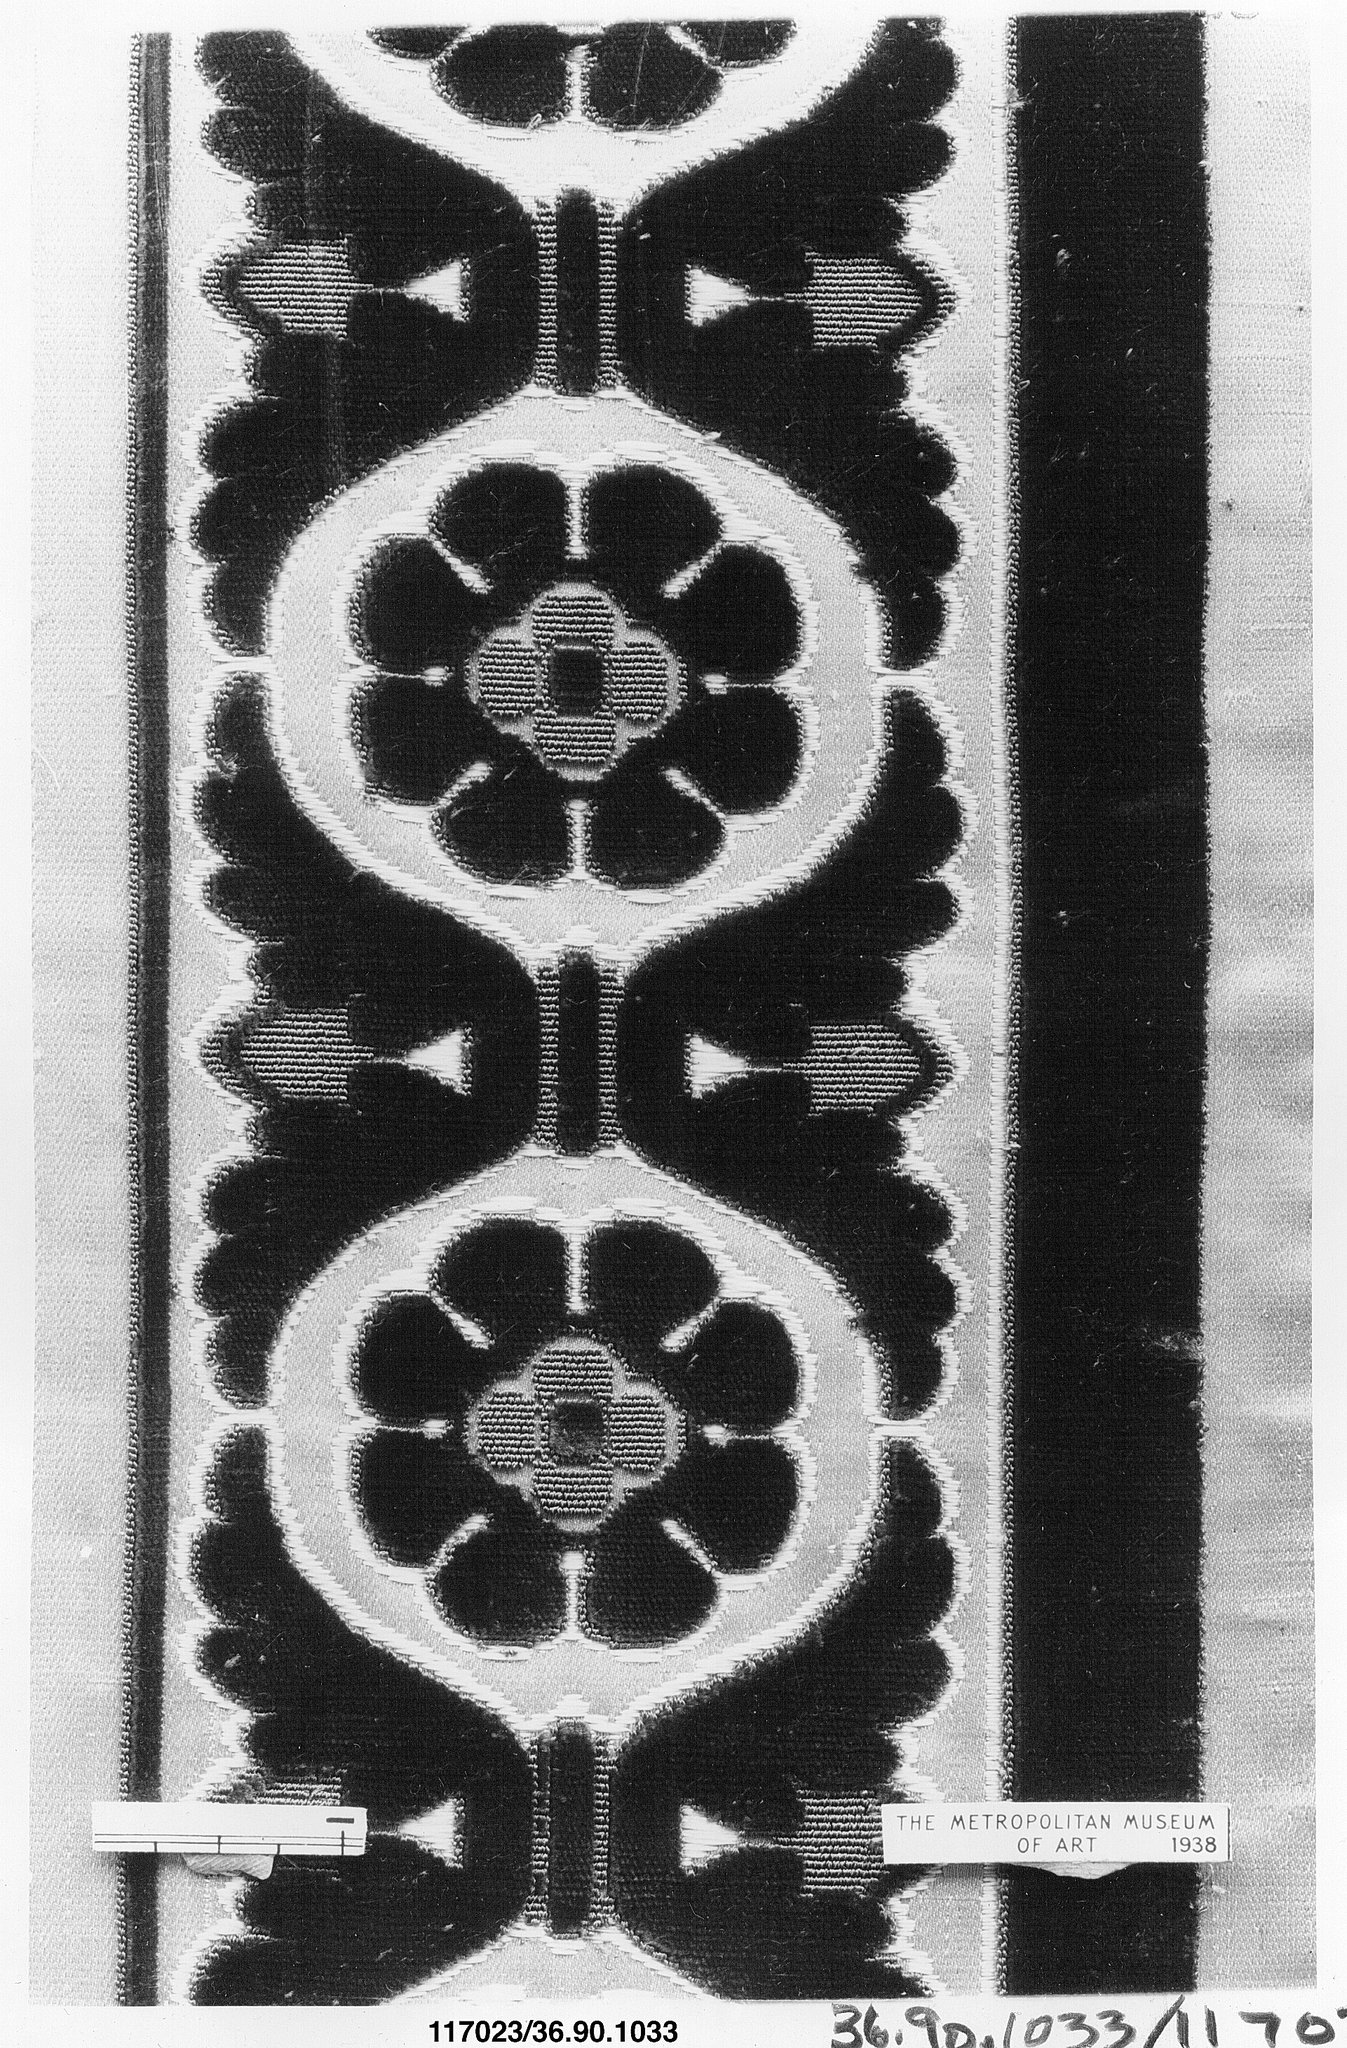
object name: border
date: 1801-1900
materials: silk